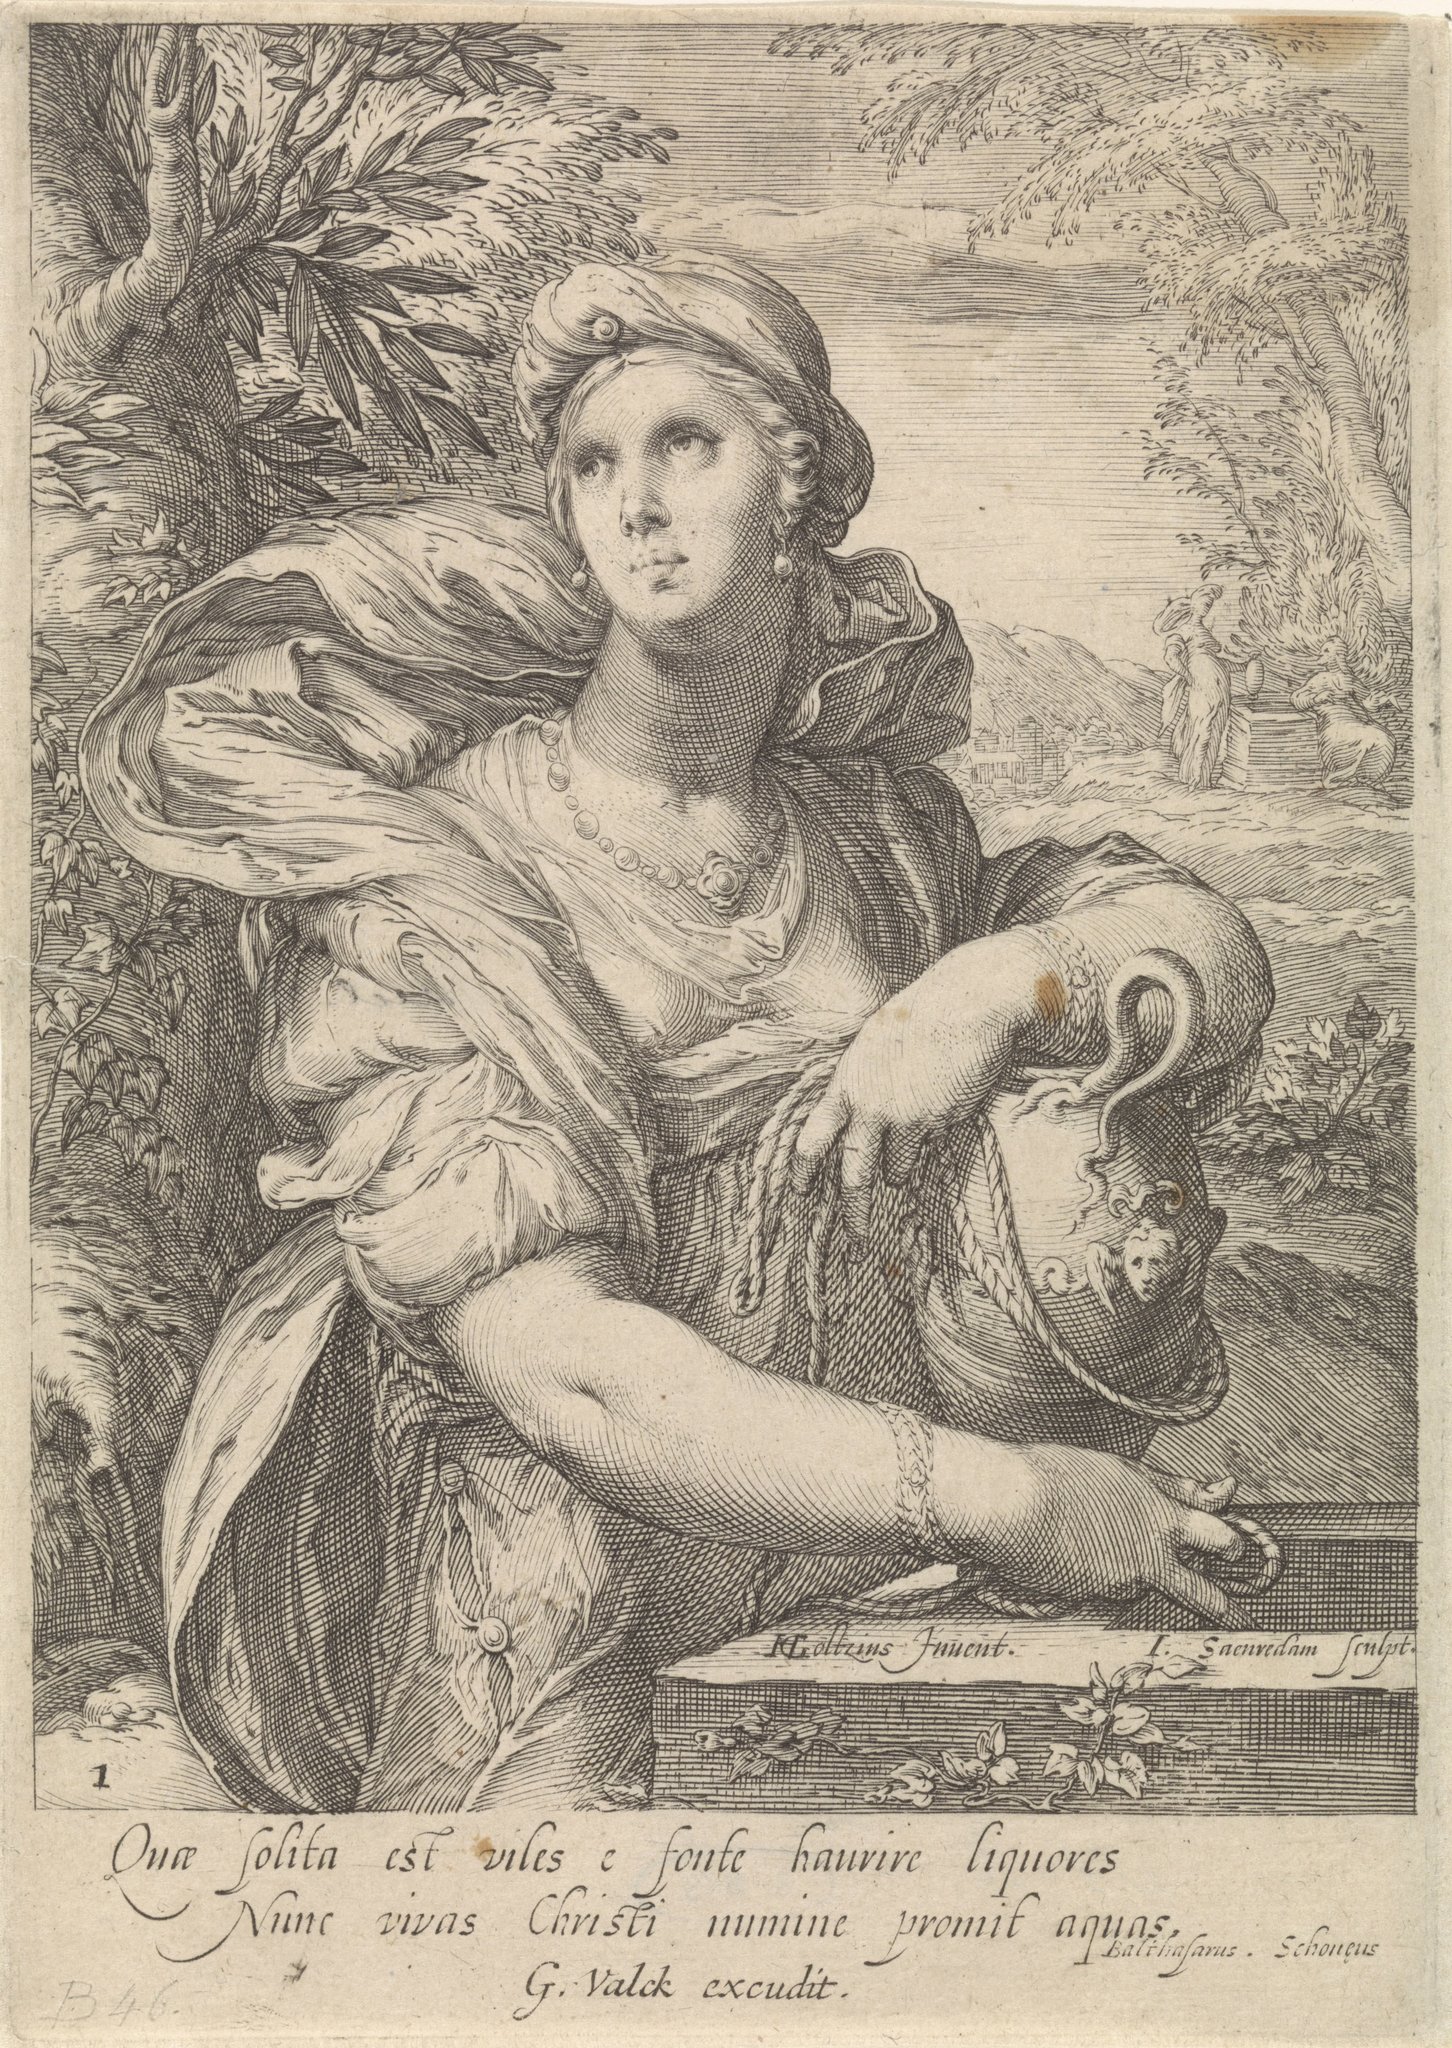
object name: print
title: De Samaritaanse vrouw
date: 1661-1726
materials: paper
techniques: engraving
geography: amsterdam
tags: christ and the woman of samaria: sitting at jacob's well he asks her for a drink from her jug, the woman of samaria (john 4:4-42)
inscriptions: collector's mark: Lugt 2228, inscription: ‘deel 33’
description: De Samaritaanse vrouw bij de waterput, een waterkruik in haar hand. Op de achtergrond de ontmoeting tussen Christus en de Samaritaanse vrouw bij de bron. De prent heeft een Latijns onderschrift en maakt deel uit van een prentserie met beroemde vrouwen uit het Nieuwe Testament